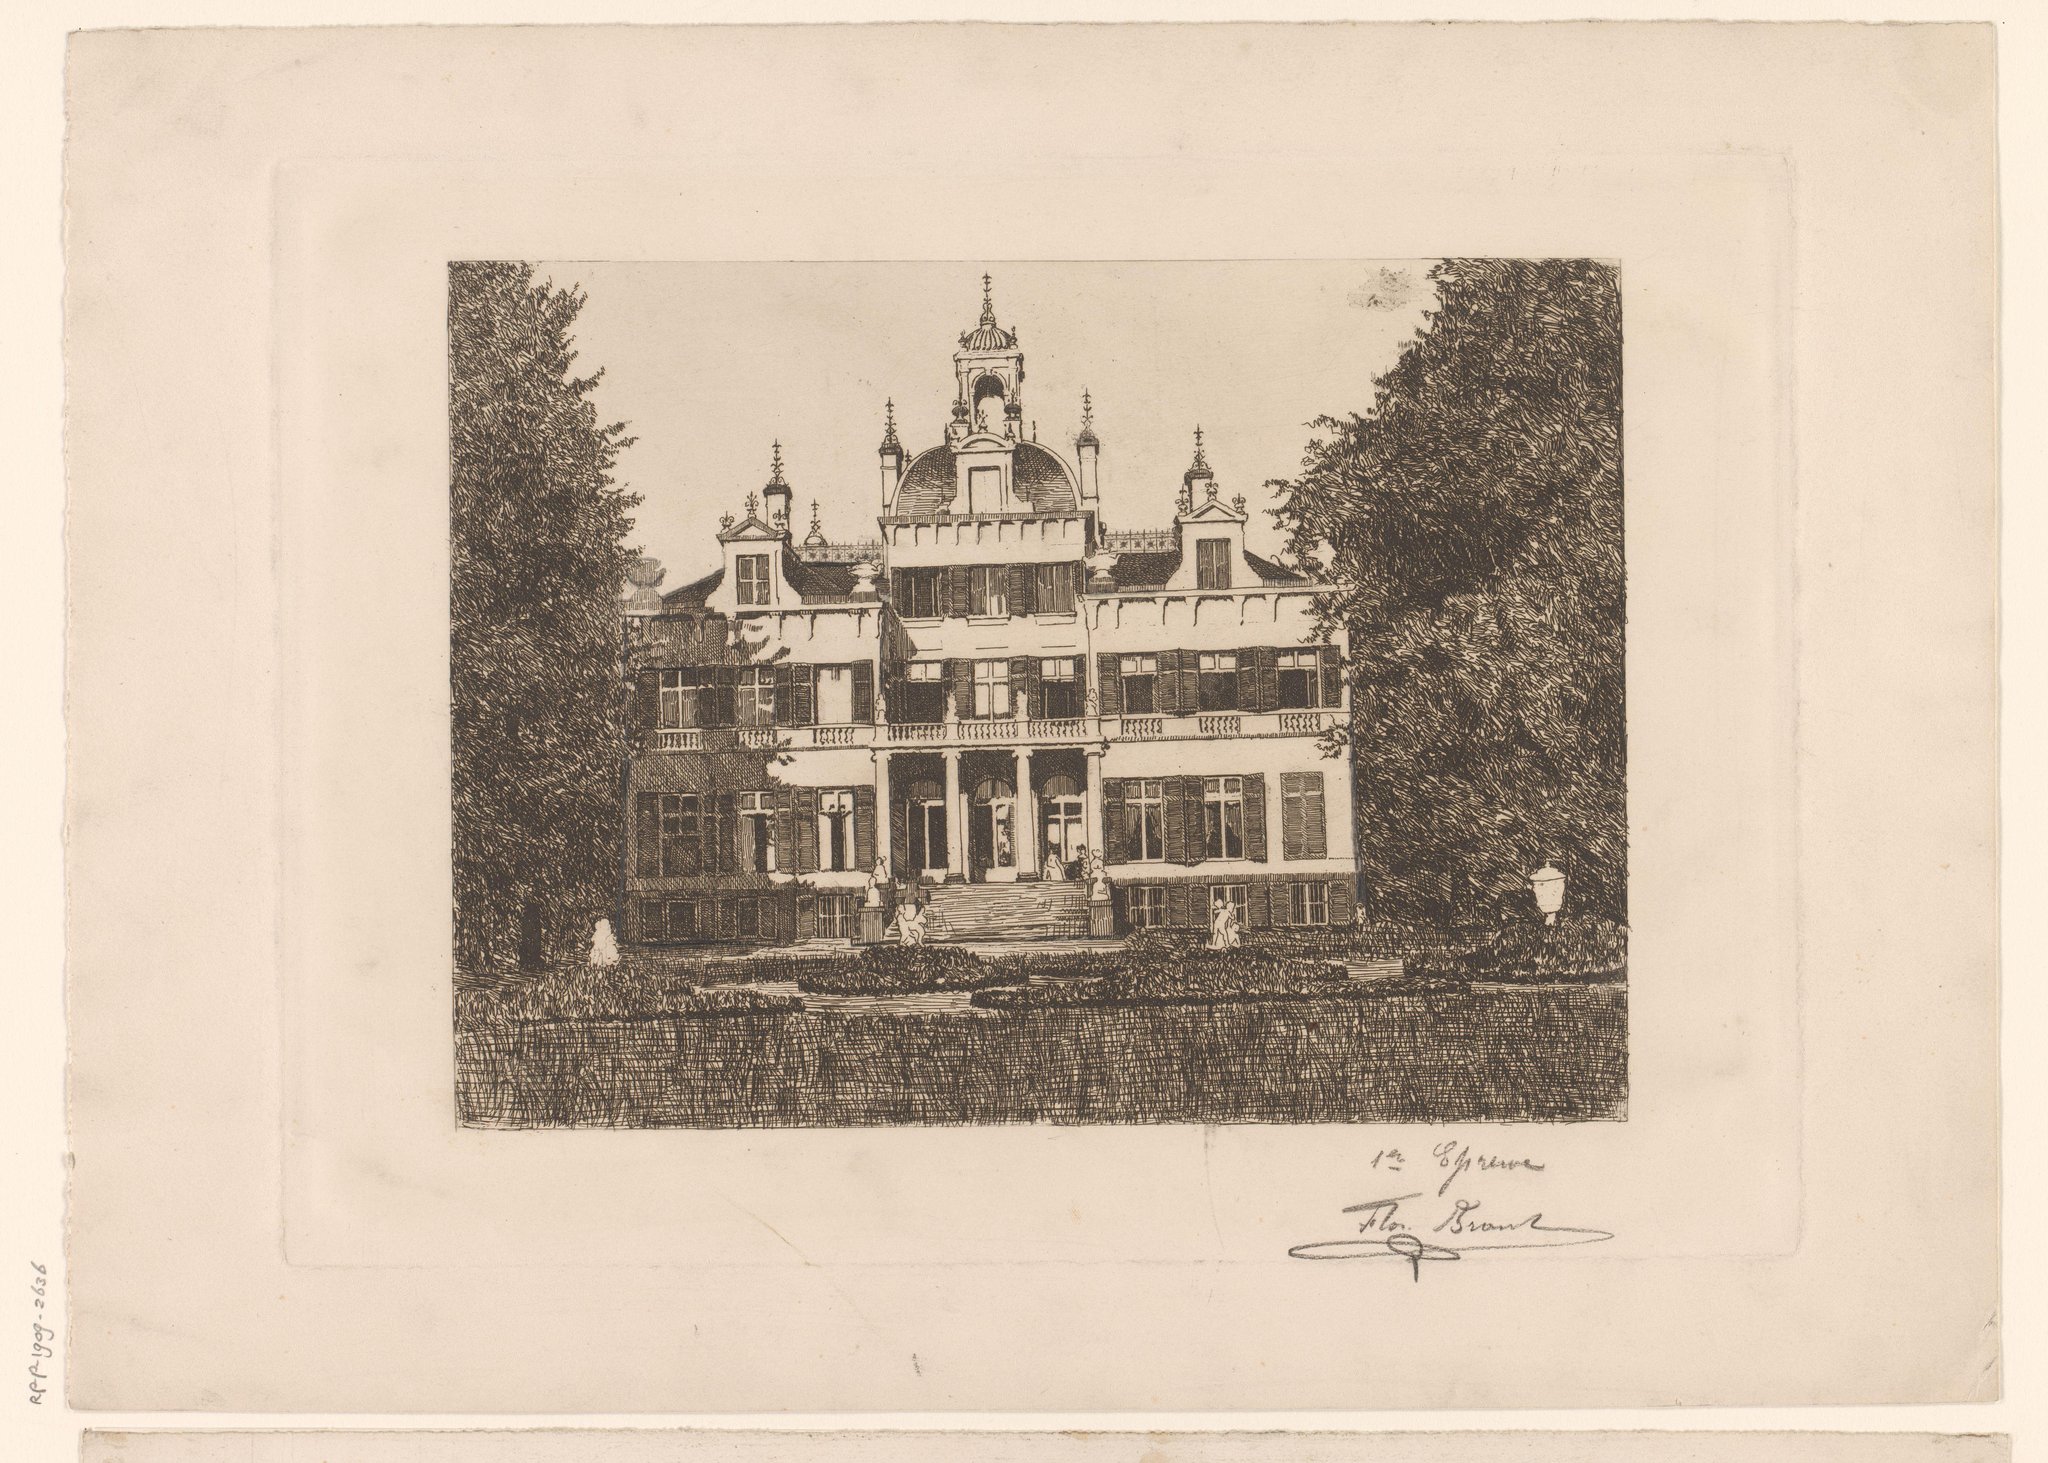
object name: print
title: Hof ter Mick te Brasschaat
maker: florent brant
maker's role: print maker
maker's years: 1863-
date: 1873-1909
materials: paper, pencil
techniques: etching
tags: castle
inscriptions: inscription: ‘1e Epreuve’, collector's mark: Lugt 2228